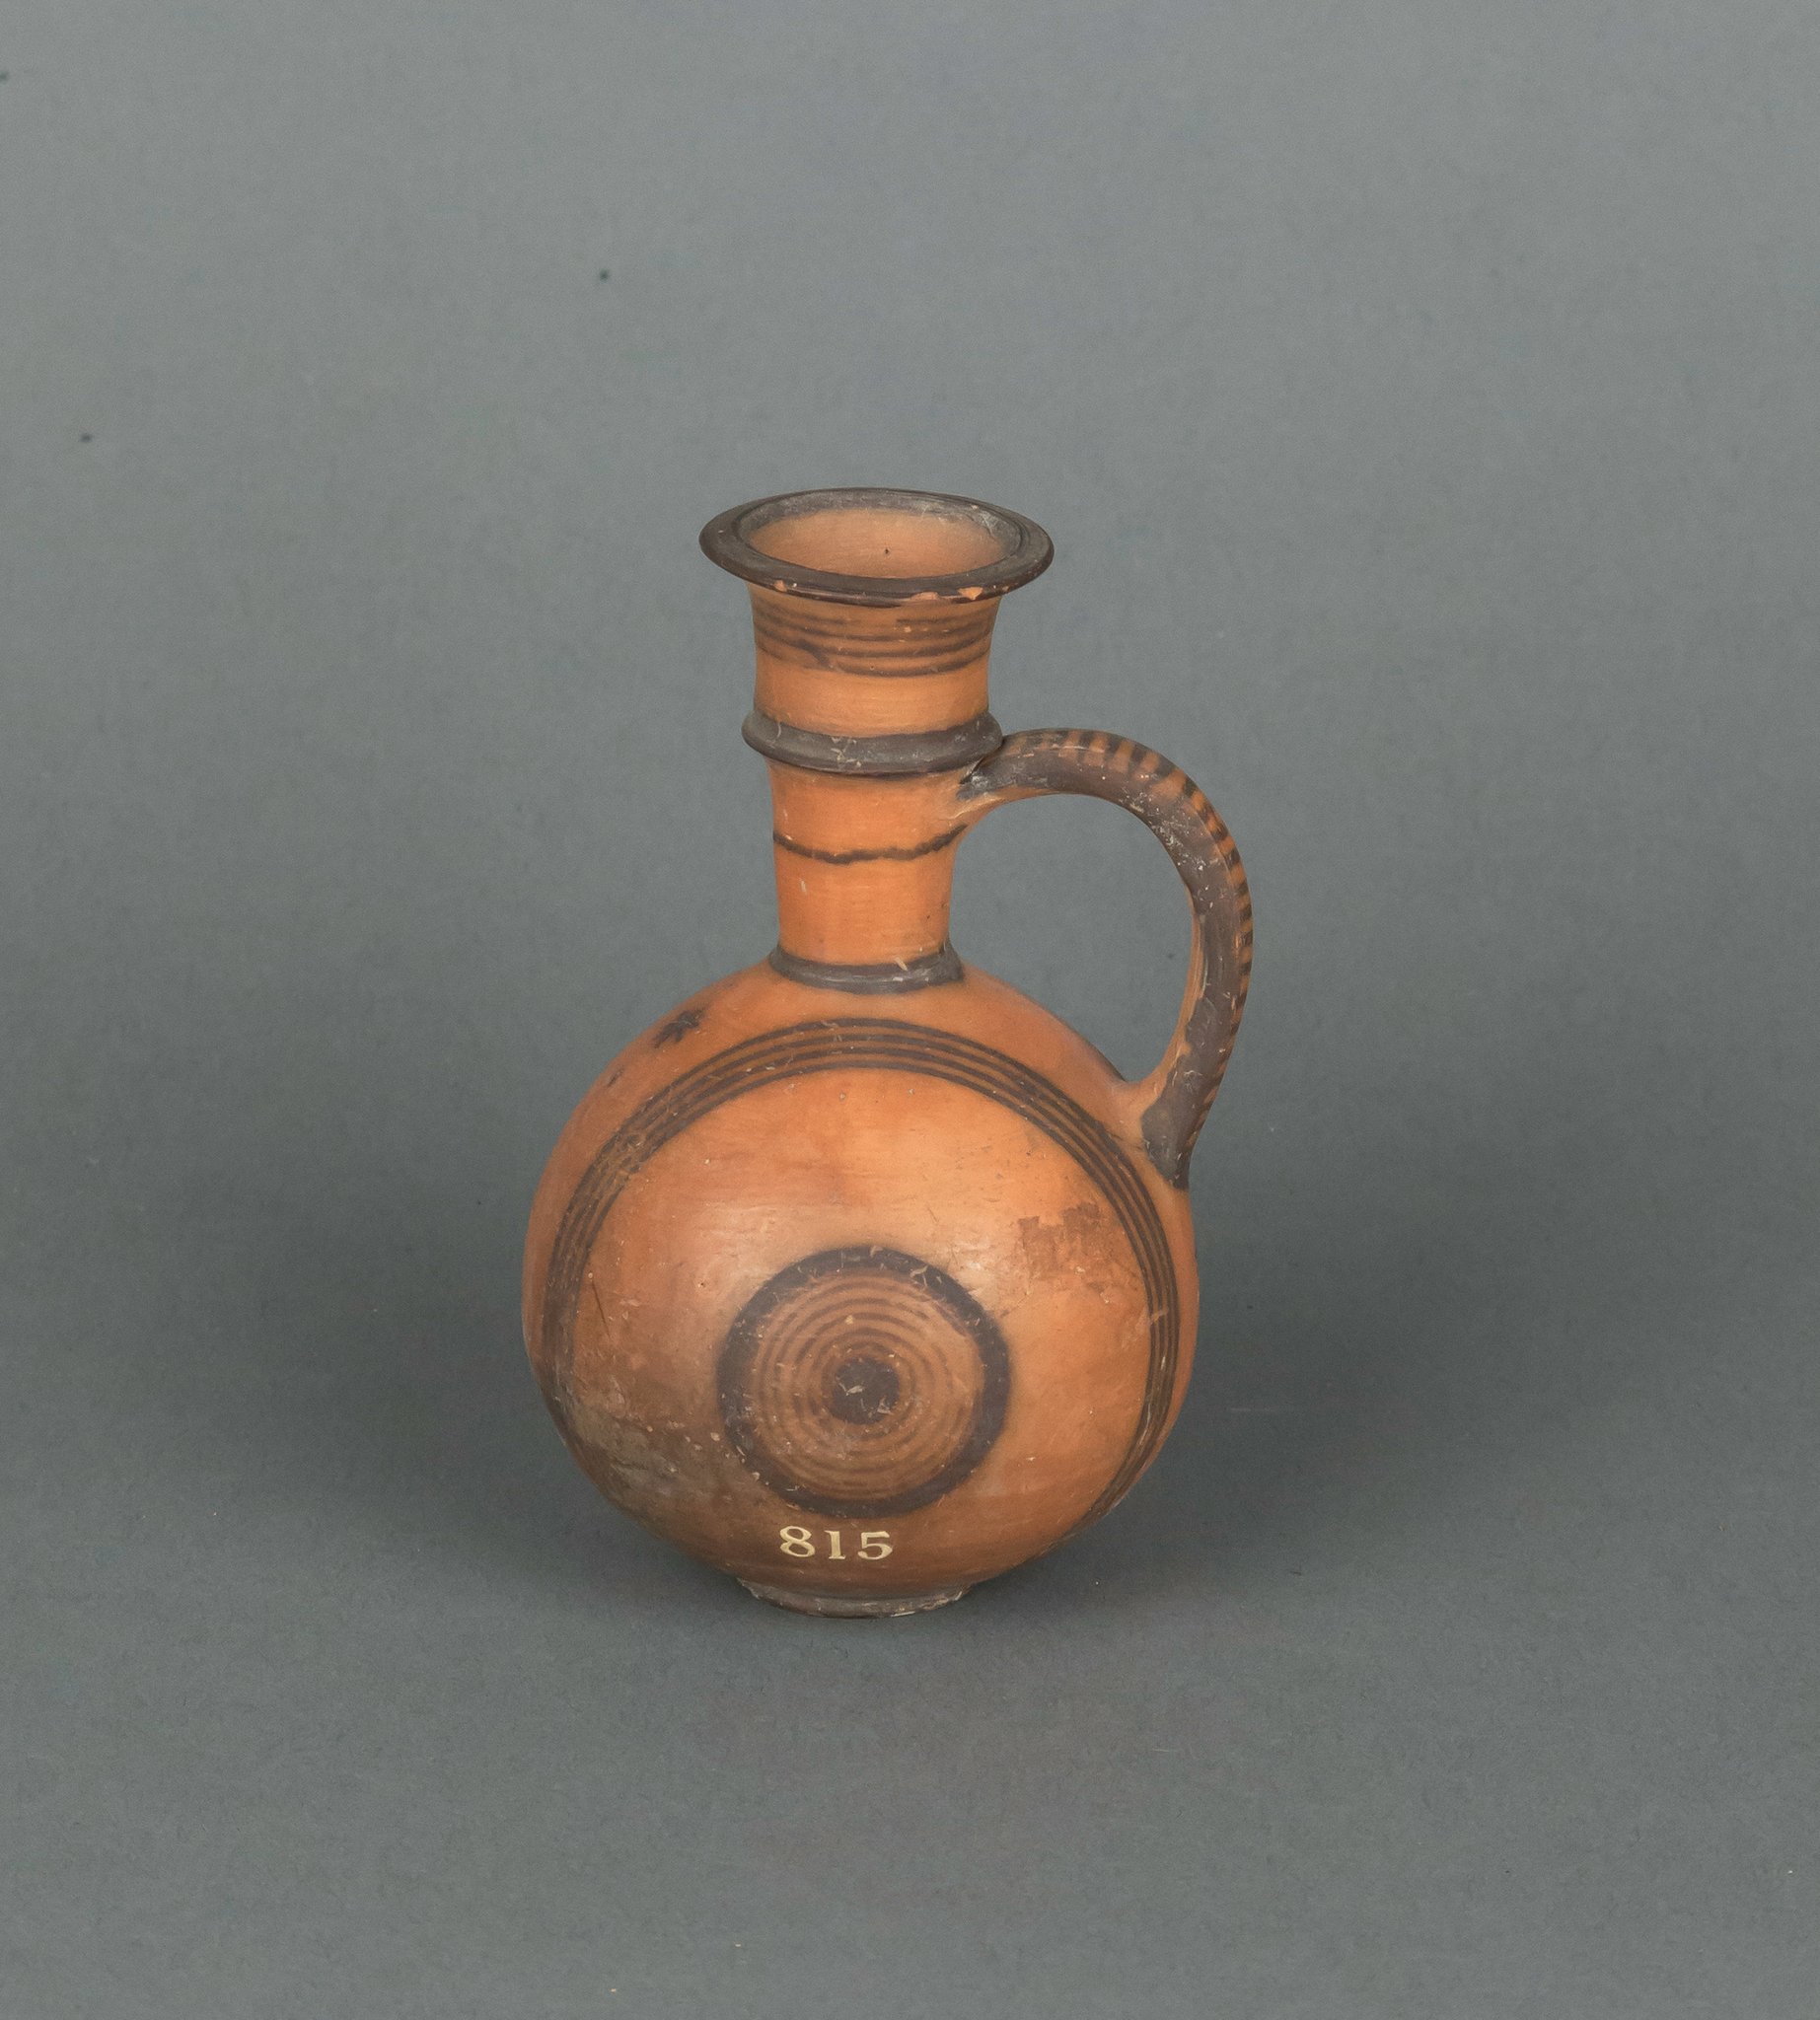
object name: jug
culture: cypriot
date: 1050-900 BCE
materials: terracotta